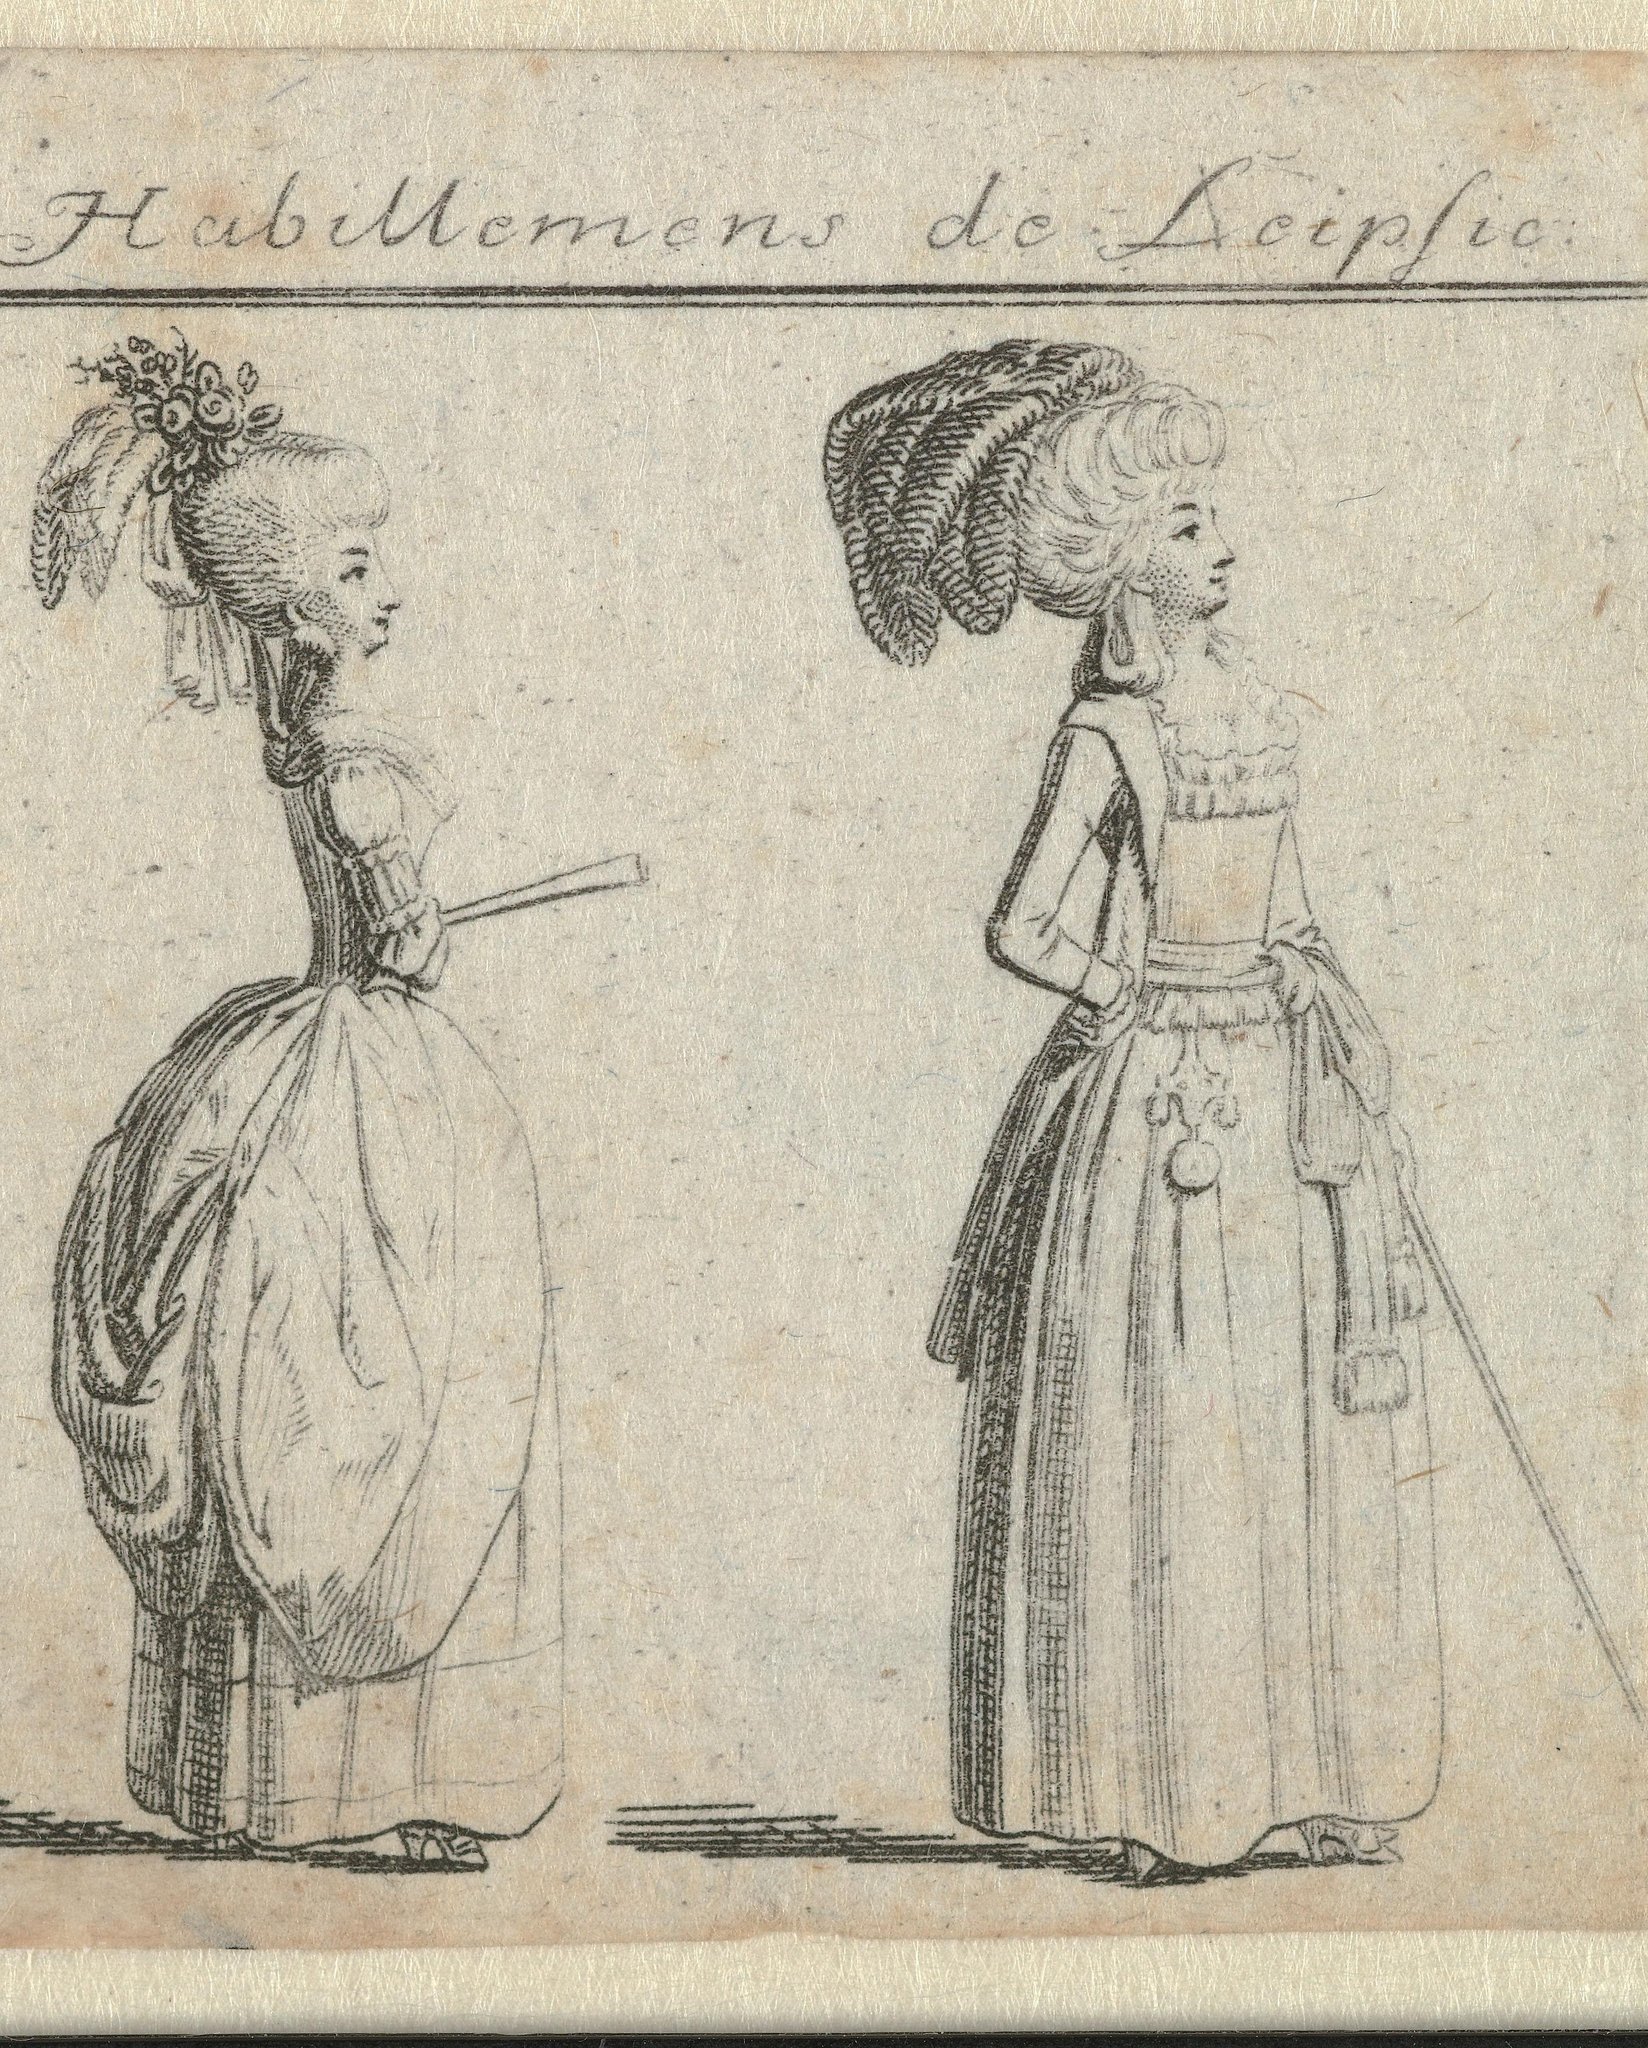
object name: fashion print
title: Habillemens de Leipsic ca. 1785-1786: twee vrouwen met waaier en wandelstok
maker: ernst ludwig riepenhausen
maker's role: print maker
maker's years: 1765-1840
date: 1785-1786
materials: paper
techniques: etching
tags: calendar, almanac, walking-stick, staff, cane (+ women's clothes), trousers, breeches (+ women's clothes), coat (+ women's clothes), head-gear: cap (+ women's clothes), fashion plates, dress, gown: robe à la polonaise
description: Twee staande vrouwen gekleed in een robe à la Polonaise met rok (links) en een japon met om het middel een sjerp met franjes (rechts). Kapsels versier met veren. Accessoires: waaier, wandelstok, chatelaine, schoenen met hakken. De prent maakt deel uit van de almanak Habillemens de Leipzig, ca. 1785-1786.